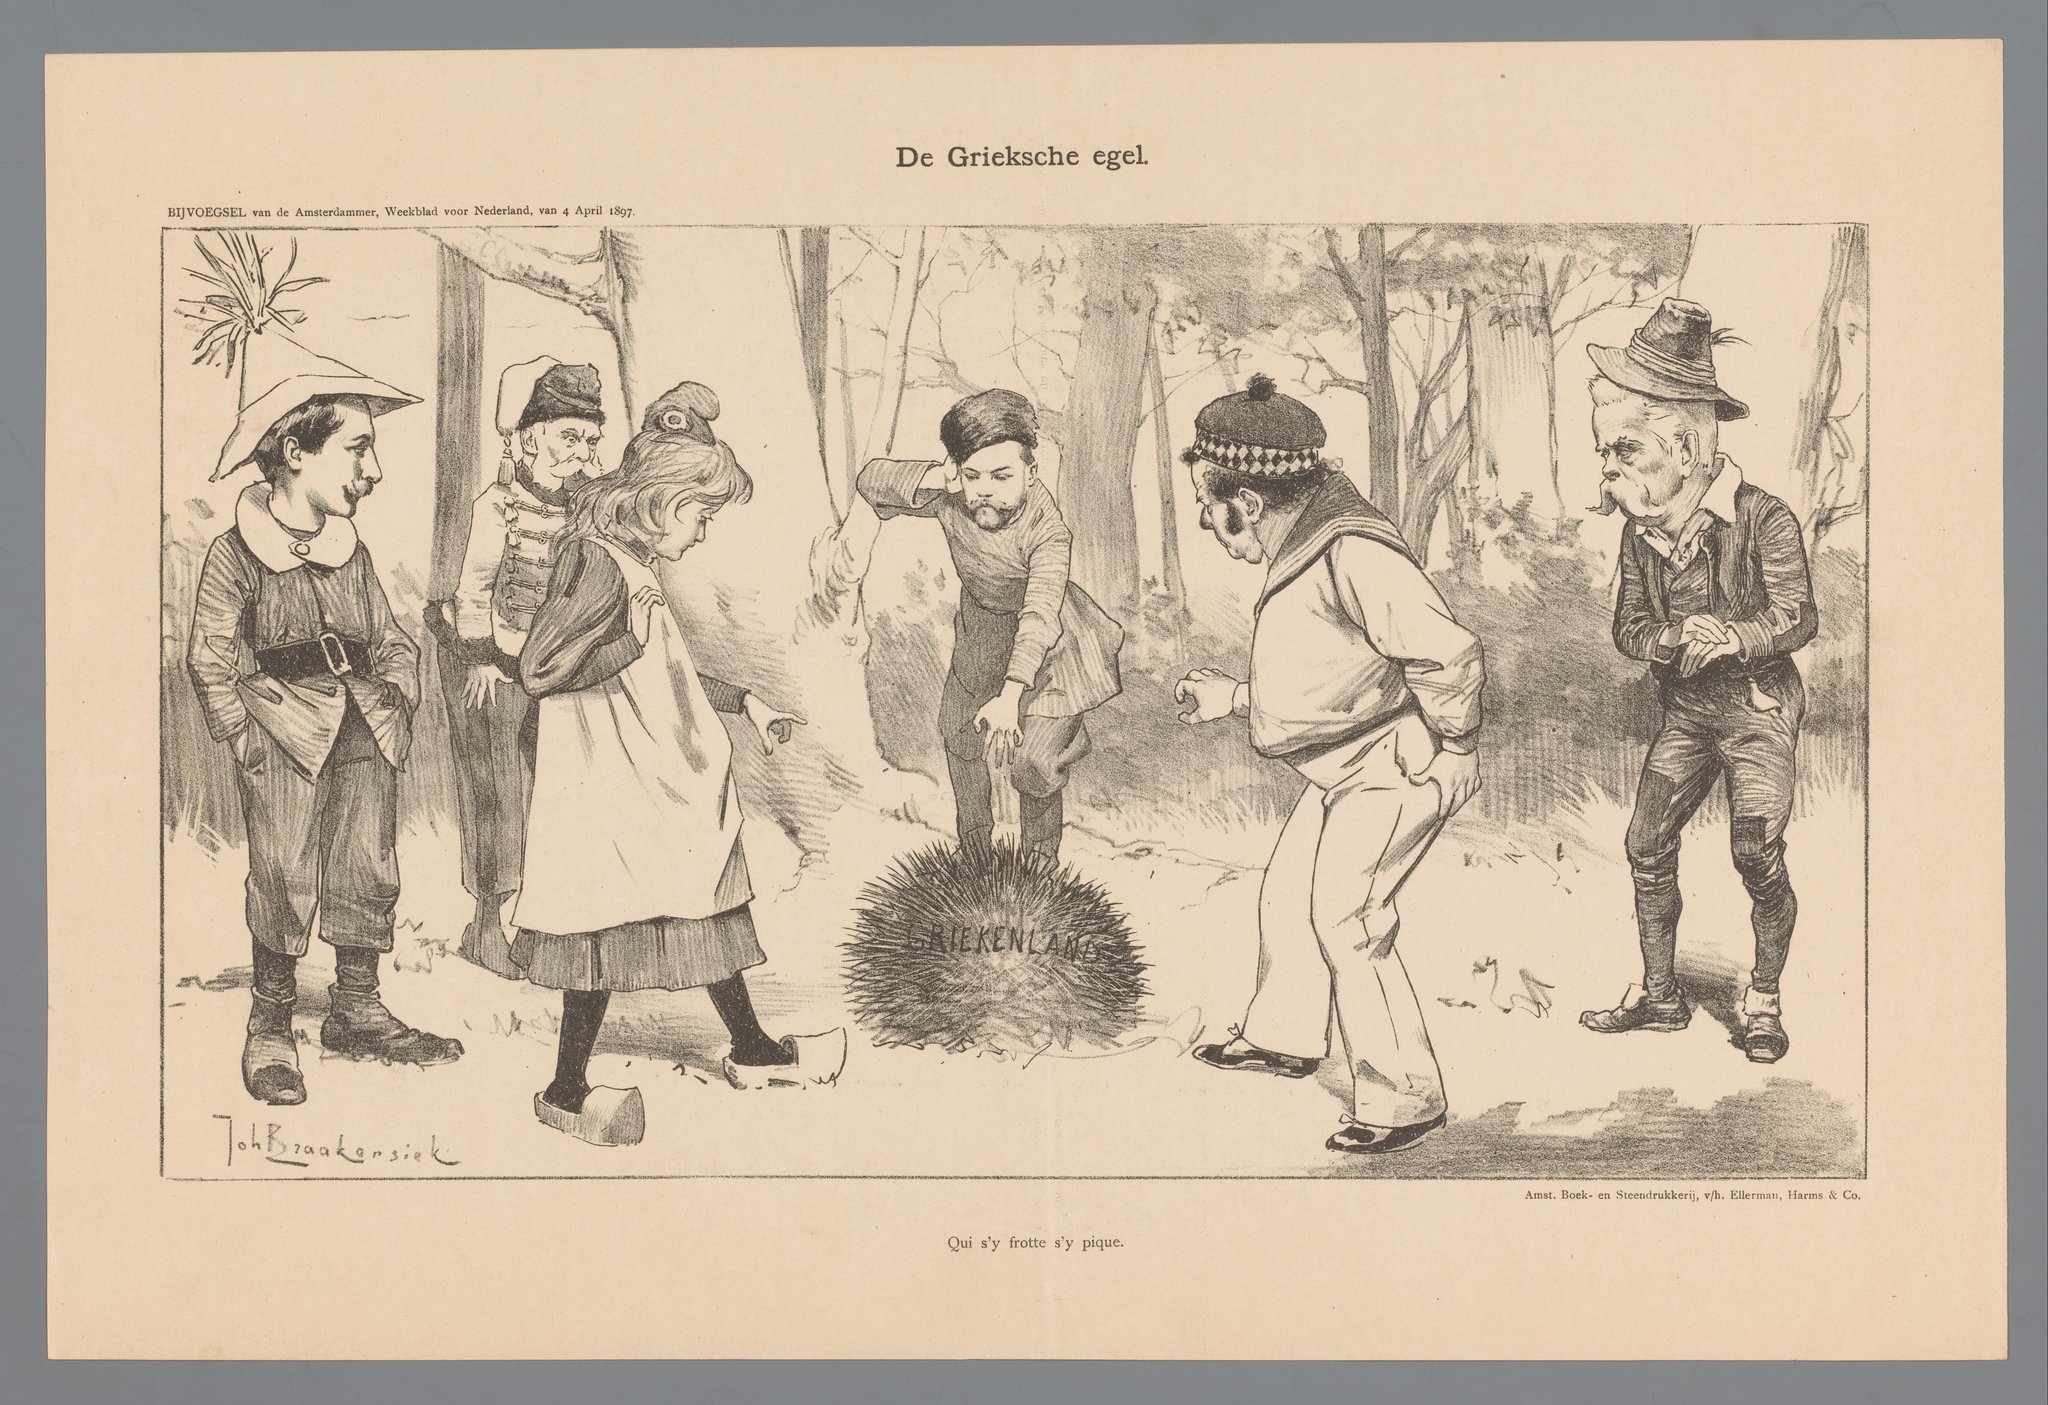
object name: cartoon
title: De Grieksche egel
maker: johan braakensiek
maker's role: draughtsman, print maker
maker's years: 1858-1940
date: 1897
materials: paper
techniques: lithograph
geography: amsterdam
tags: personifications of countries, nations, states, districts, etc., historical persons, other mammals: hedgehog, political caricatures and satires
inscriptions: date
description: Prent uit het bijvoegsel van: De Amsterdammer. Weekblad voor Nederland, 4 april 1897.